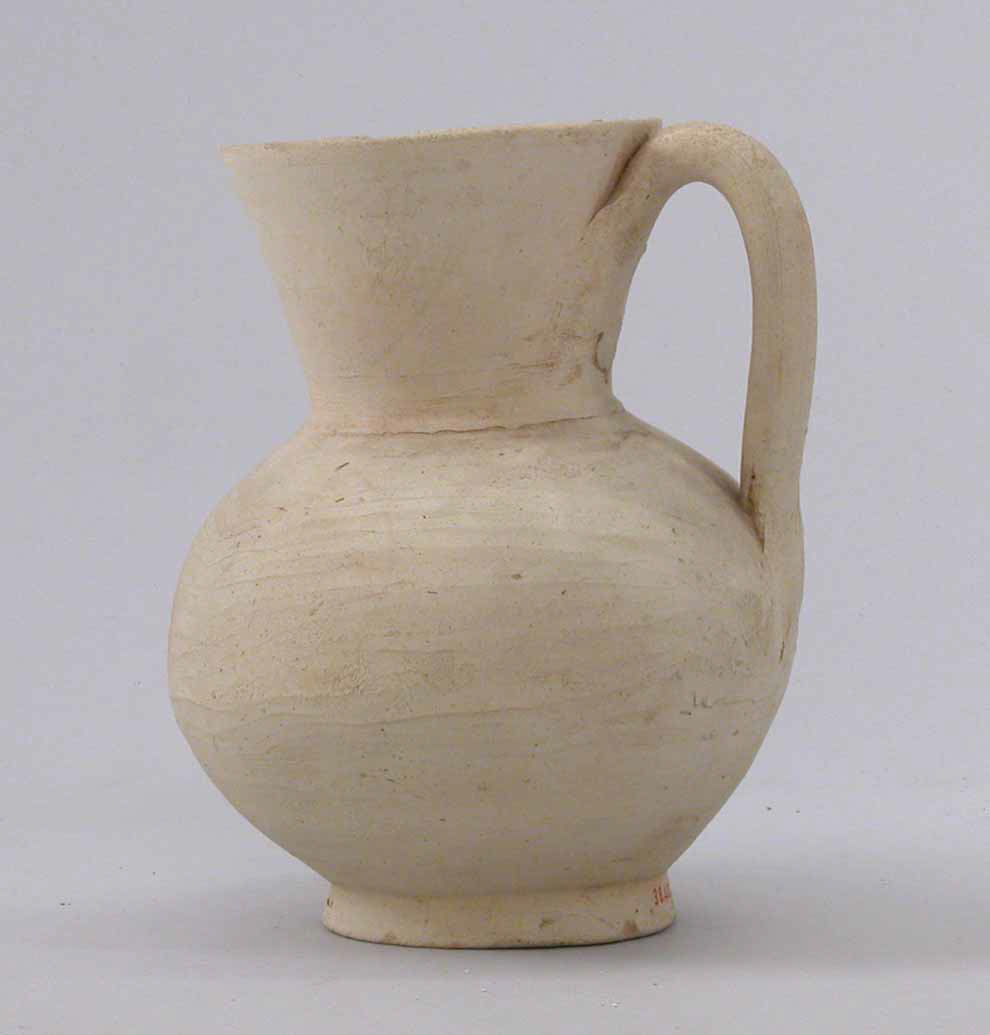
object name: jar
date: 701-833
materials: earthenware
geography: iran